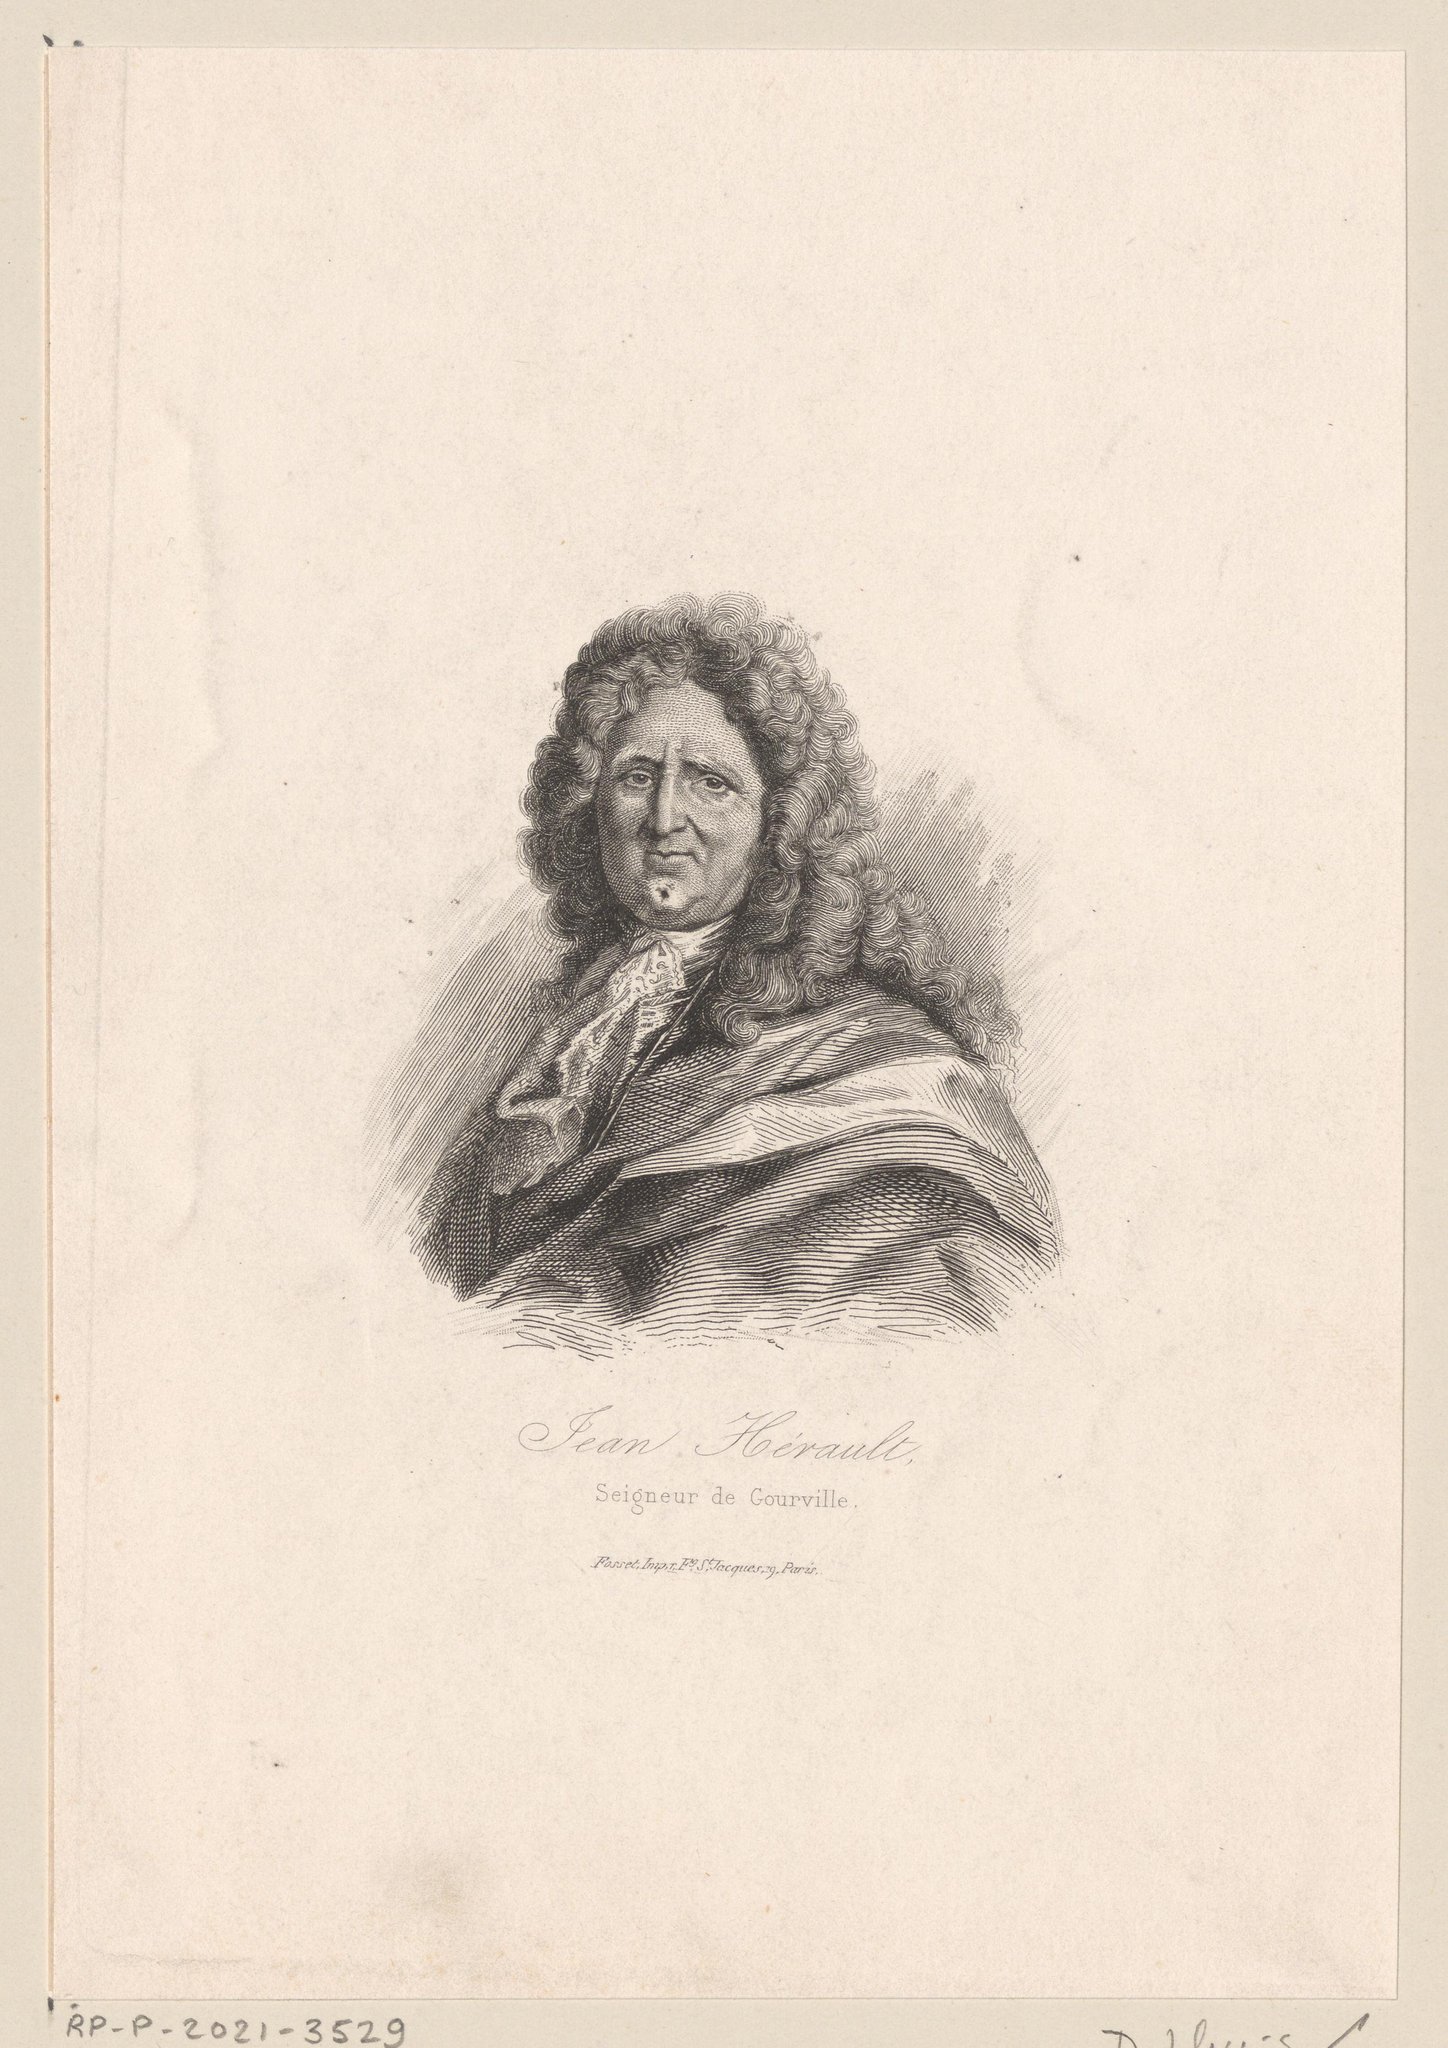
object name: print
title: Portret van Jean Hérault de Gourville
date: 1800-1849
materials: paper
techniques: engraving, etching, roulette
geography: paris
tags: historical persons